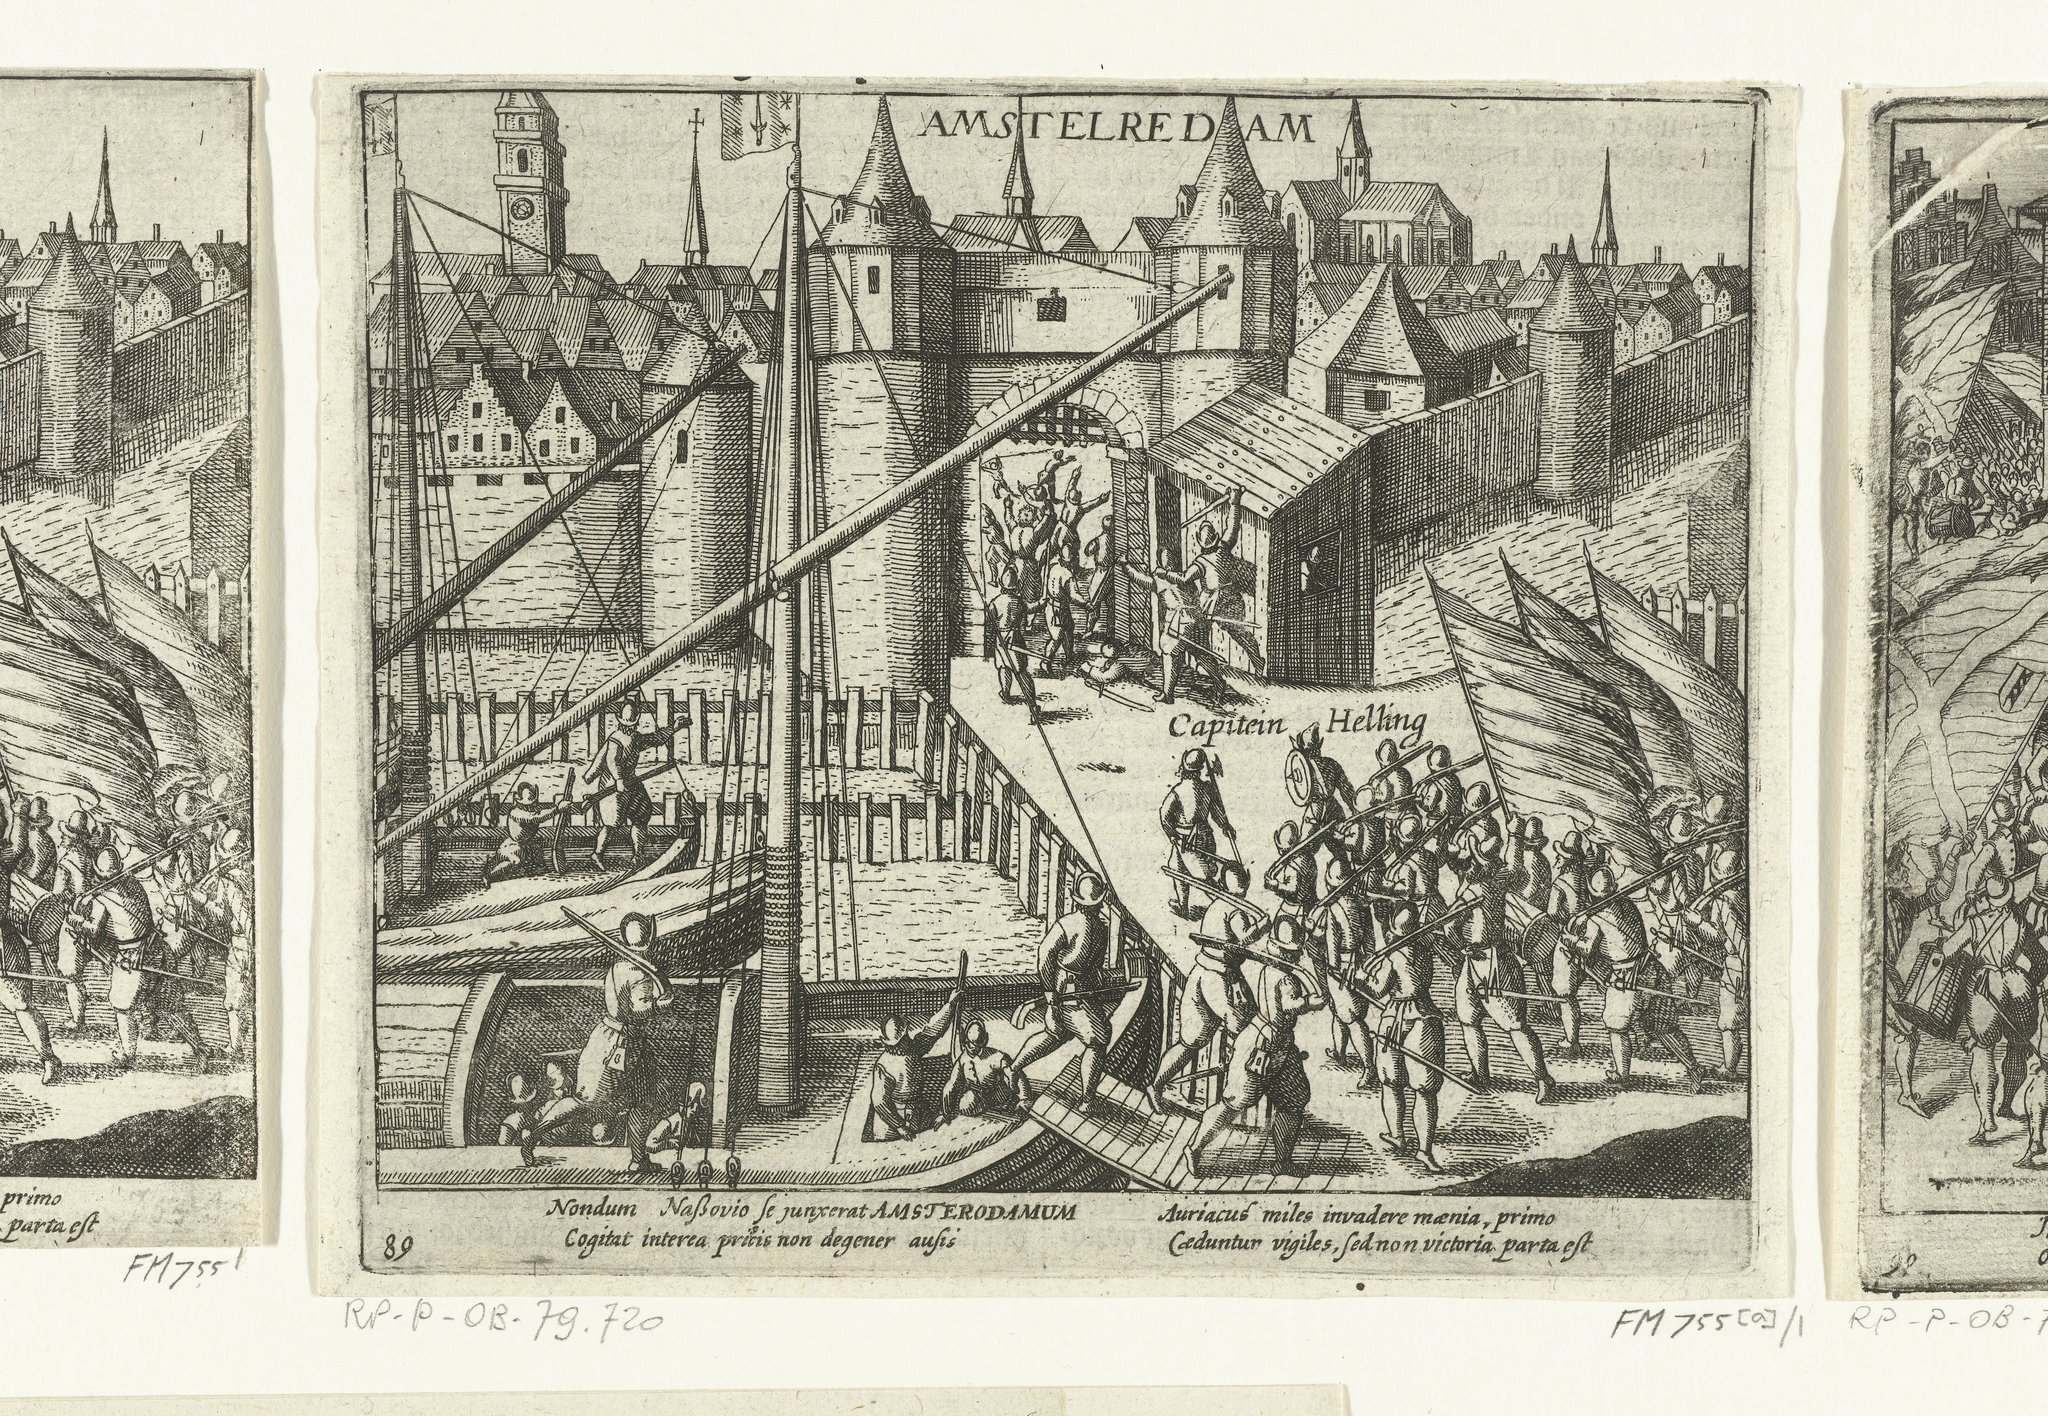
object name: history print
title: Poging om Amsterdam in te nemen, 1577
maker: Anonymous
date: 1613-1615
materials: paper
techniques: etching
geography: northern netherlands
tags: amsterdam, haarlem, battle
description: Poging van het Staatse leger onder bevel van Helling en Ruychaver om Amsterdam in te nemen, 23 november 1577. Soldaten komen uit schepen te voorschijn bij de Haarlemmerpoort. Met onderschrift van 4 regels in het Latijn. Genummerd: 89. Bedrukt op achterzijde met tekst in het Nederlands.